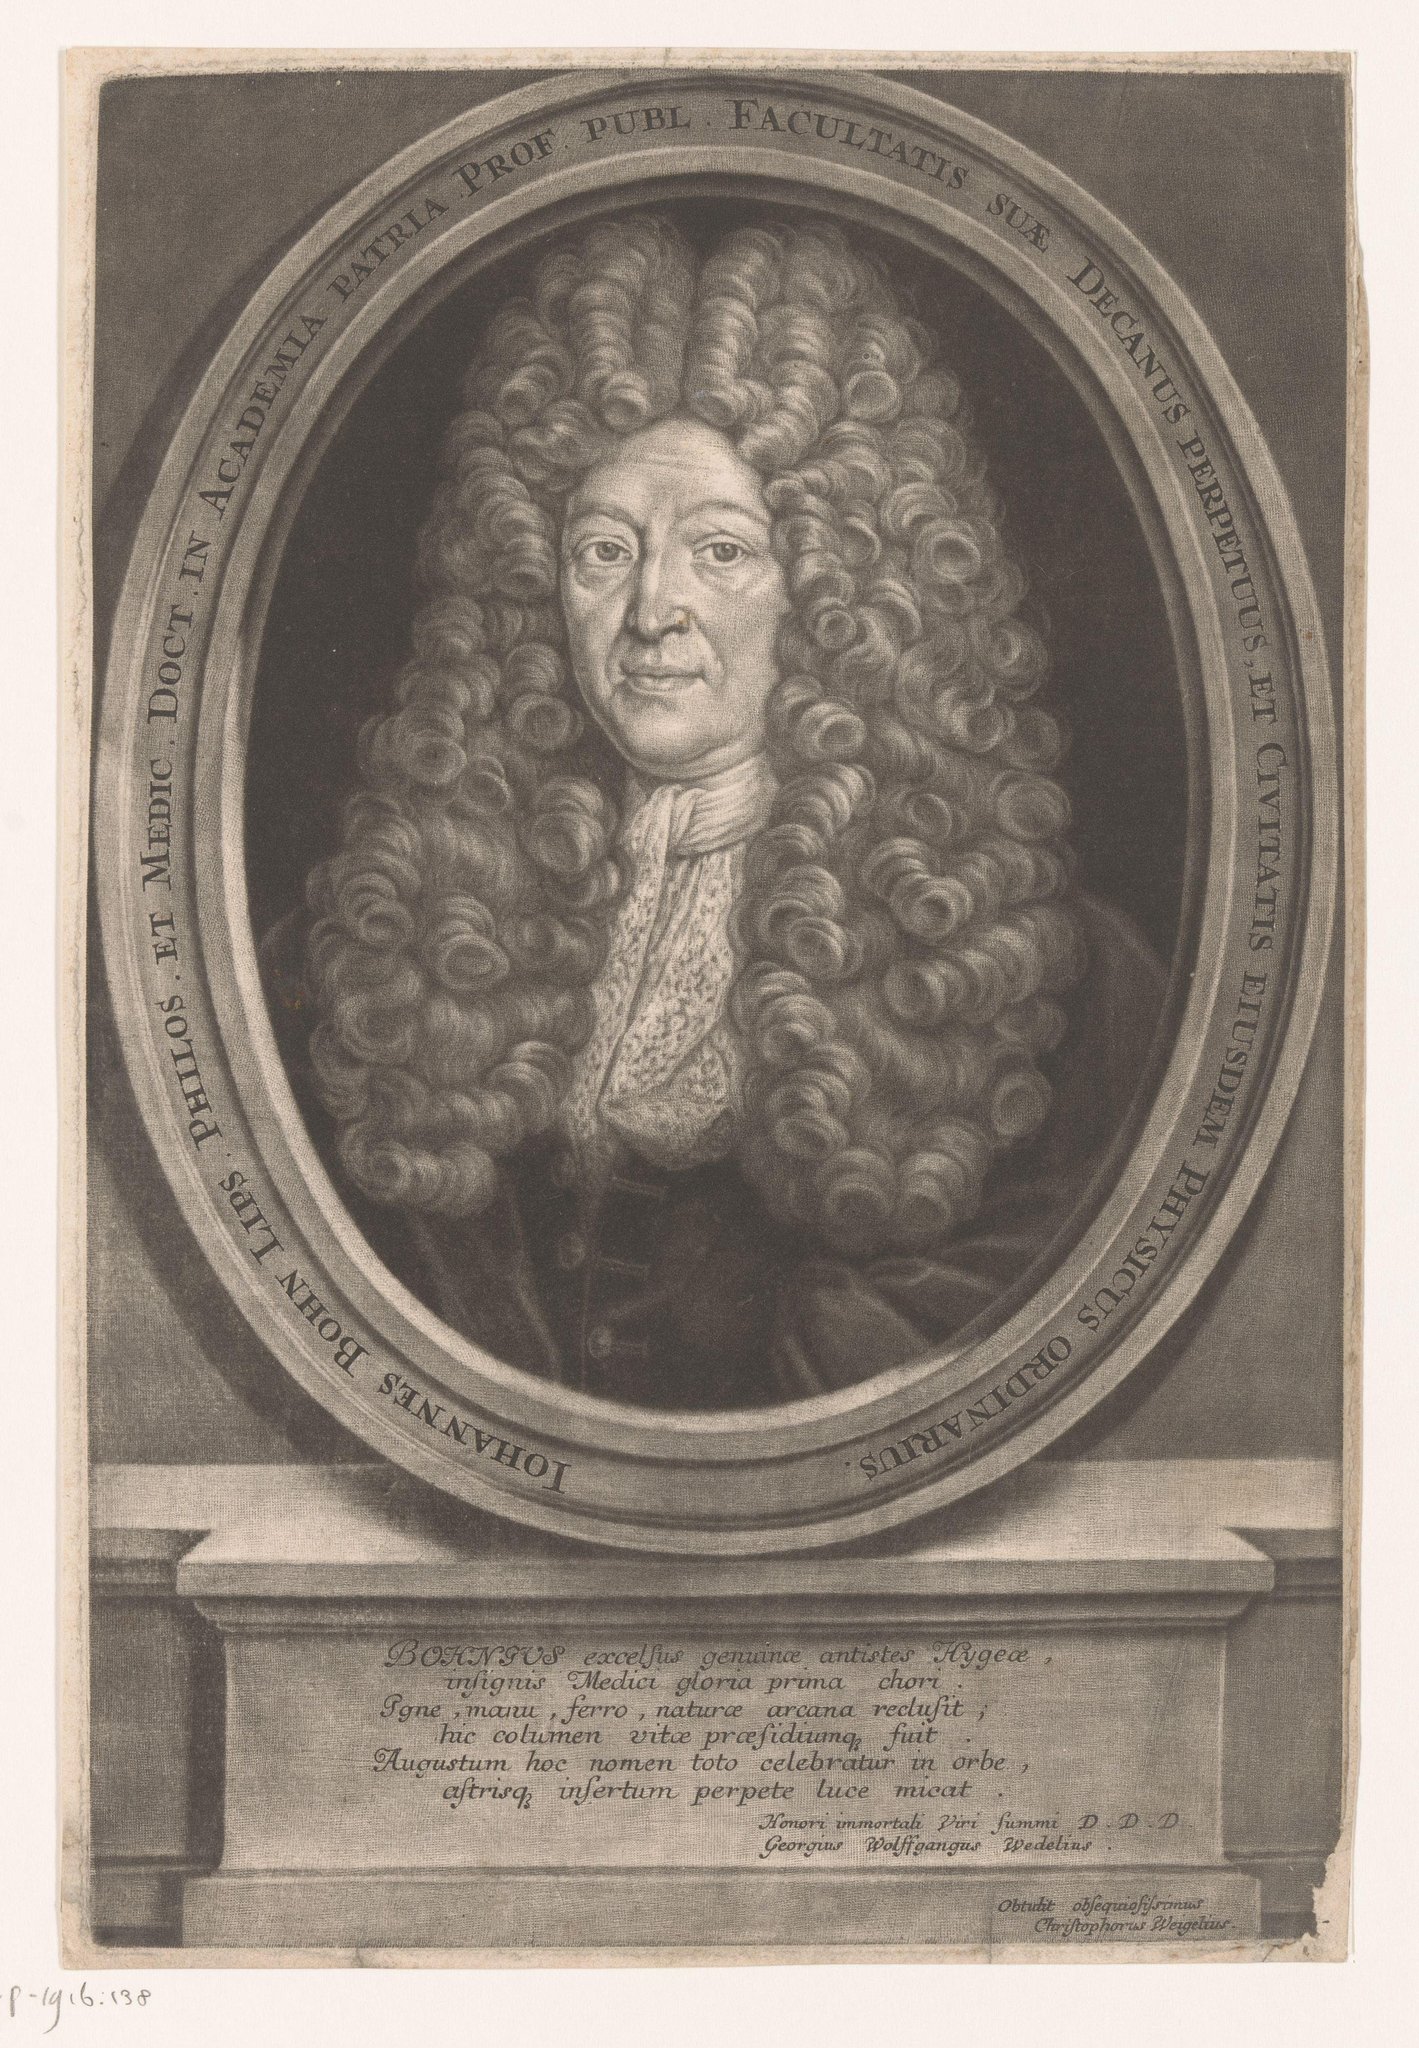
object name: print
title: Portret van Johannes Bohn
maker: christoph weigel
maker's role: goldsmith, print maker, publisher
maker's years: 1654-1725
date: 1664-1725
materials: paper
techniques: mezzotint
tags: historical persons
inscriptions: collector's mark: Lugt 2228